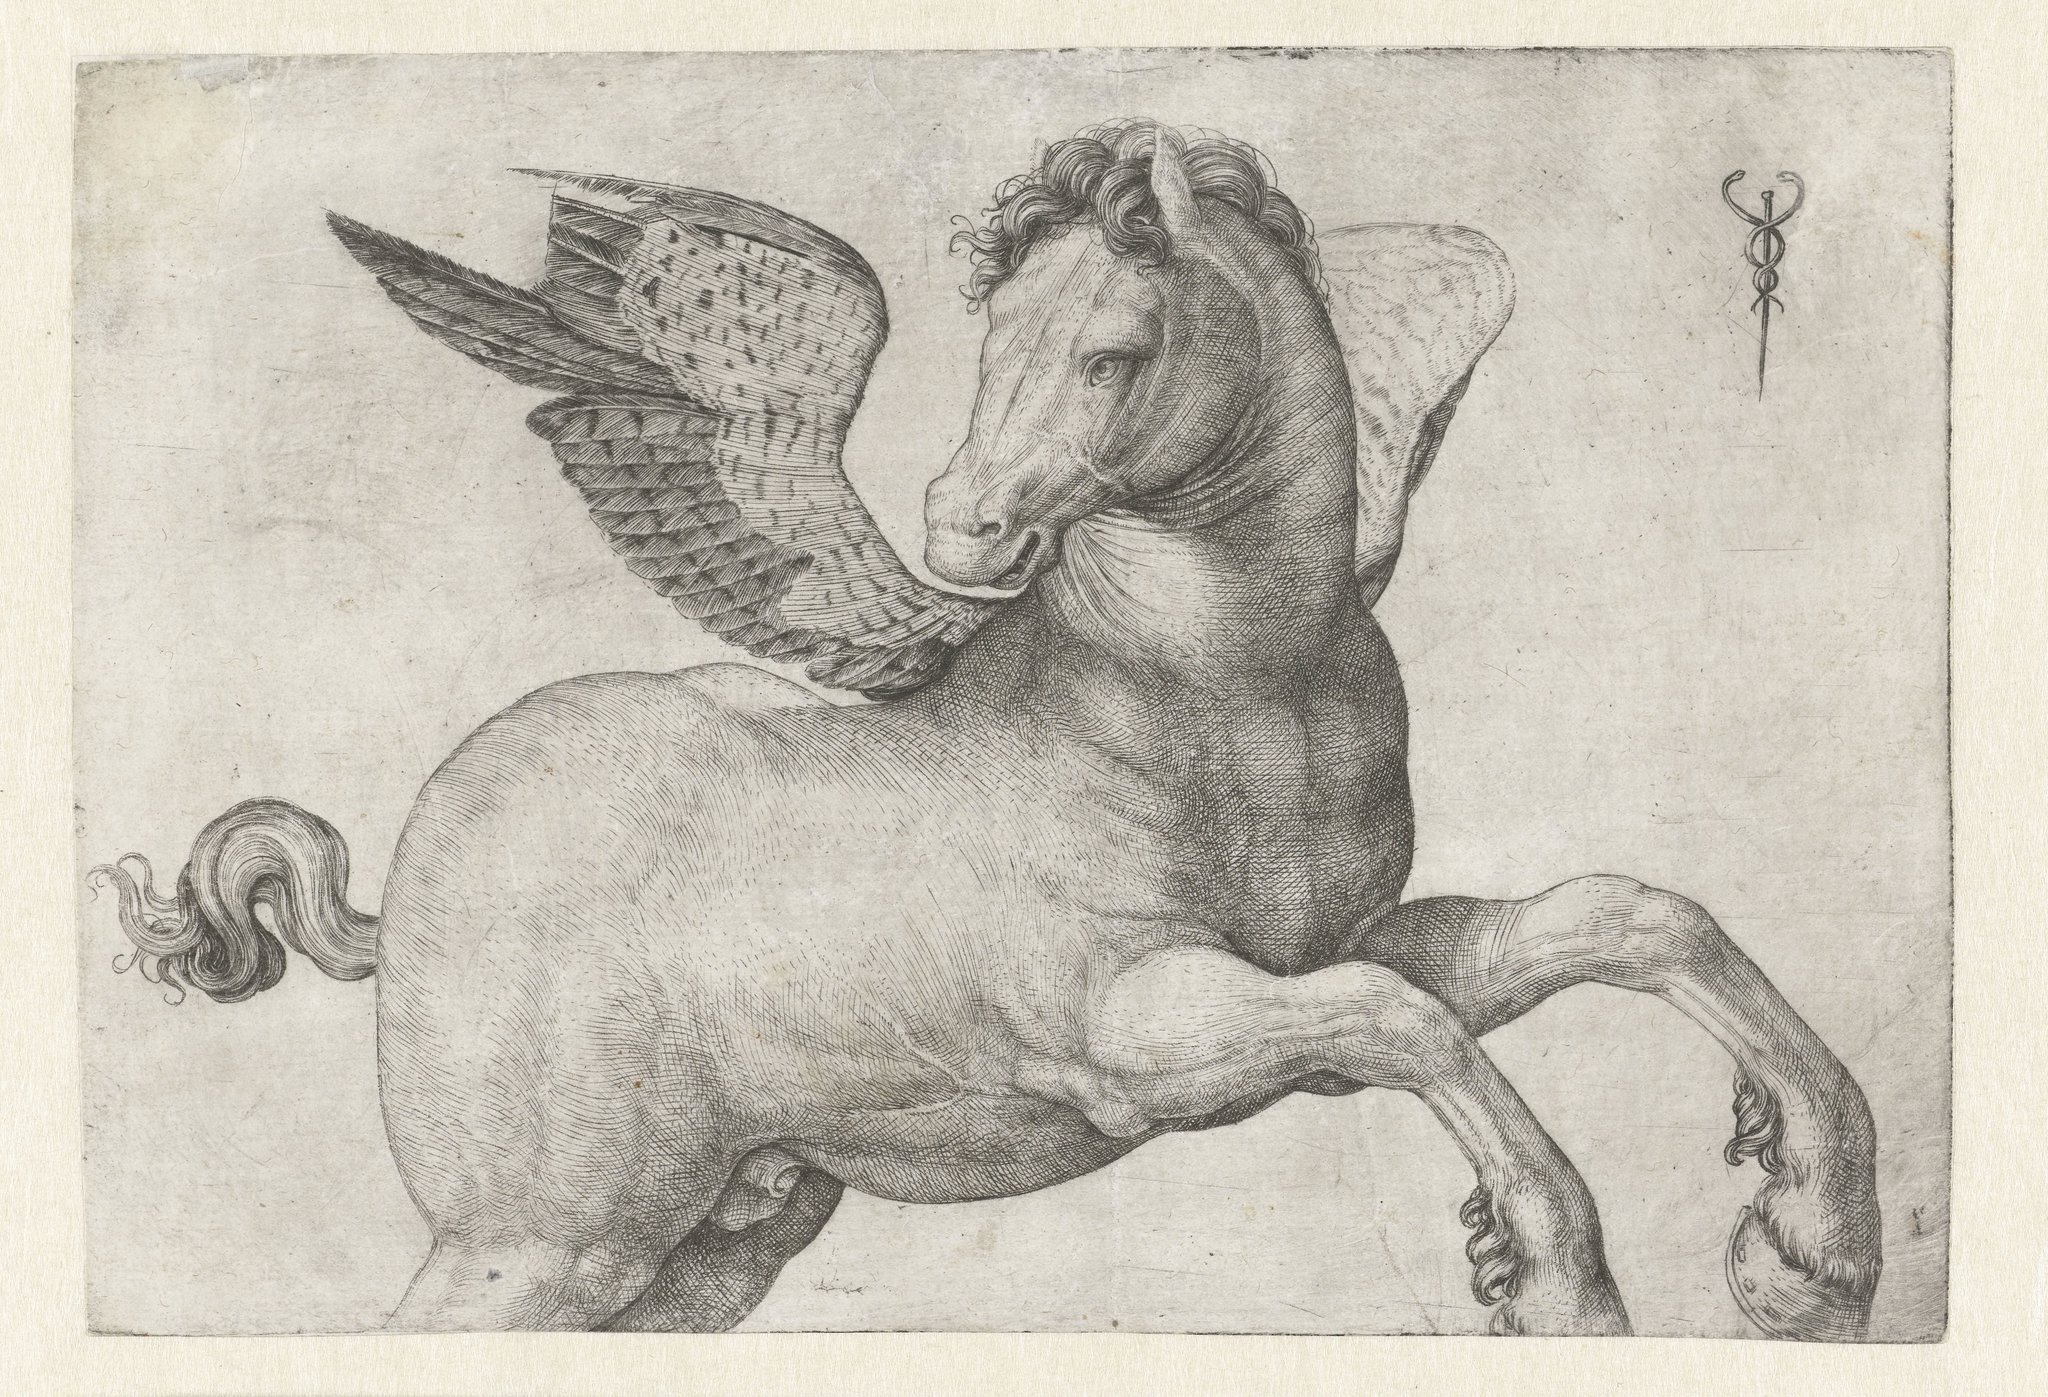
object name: print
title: Pegasus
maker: jacopo de barbari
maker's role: draughtsman, print maker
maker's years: 1440-1516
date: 1509-1516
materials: paper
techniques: engraving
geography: italy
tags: pegasus, the winged horse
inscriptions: collector's mark: Lugt 240